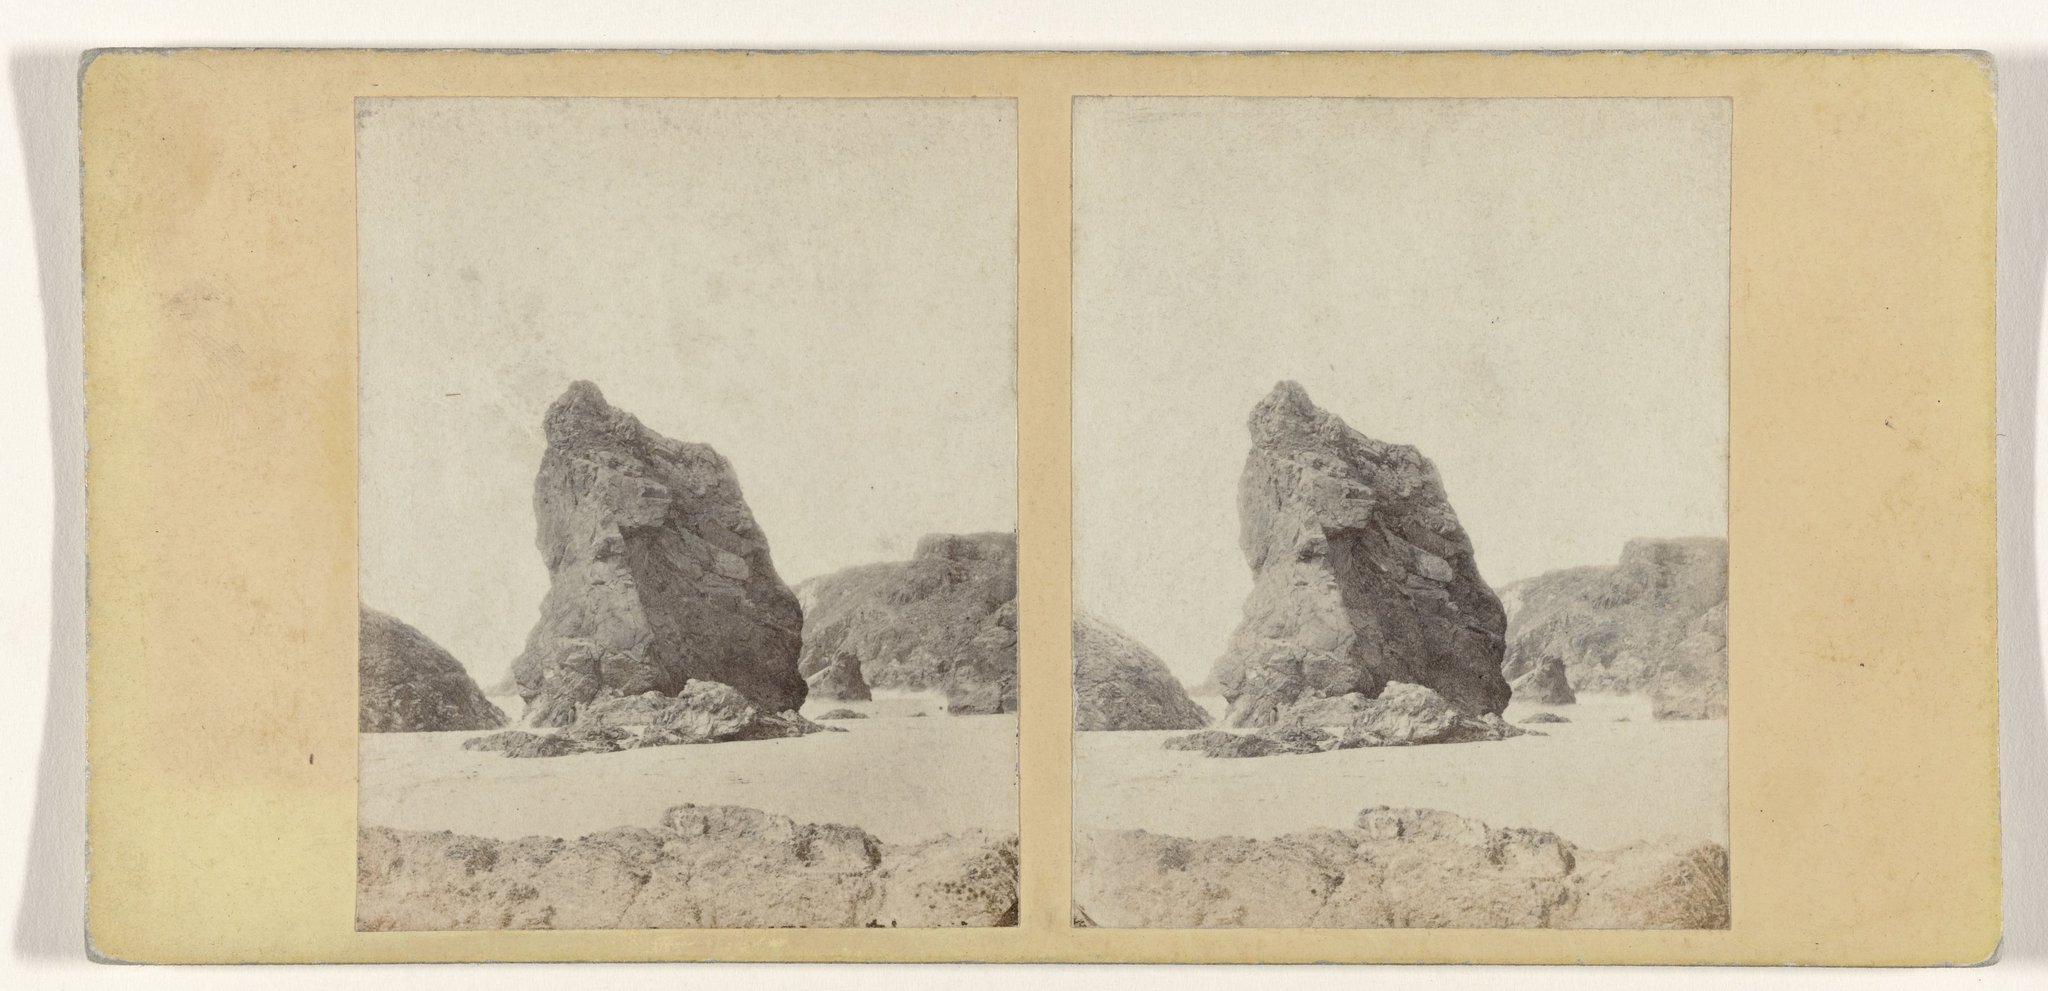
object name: stereograph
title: The steeple Rock (Serpentine), Kynance Cove, Cornwall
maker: william palmer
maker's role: fotograaf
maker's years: 1828-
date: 1808-1860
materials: cardboard, paper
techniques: albumen print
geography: cornwall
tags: rock-formations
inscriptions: inscription: ‘Chlorided fothergill process/ bilens camera roses' lenses/ August 1860 -/ From Dr. Palmer,/ Bracebridge/ Lincoln’